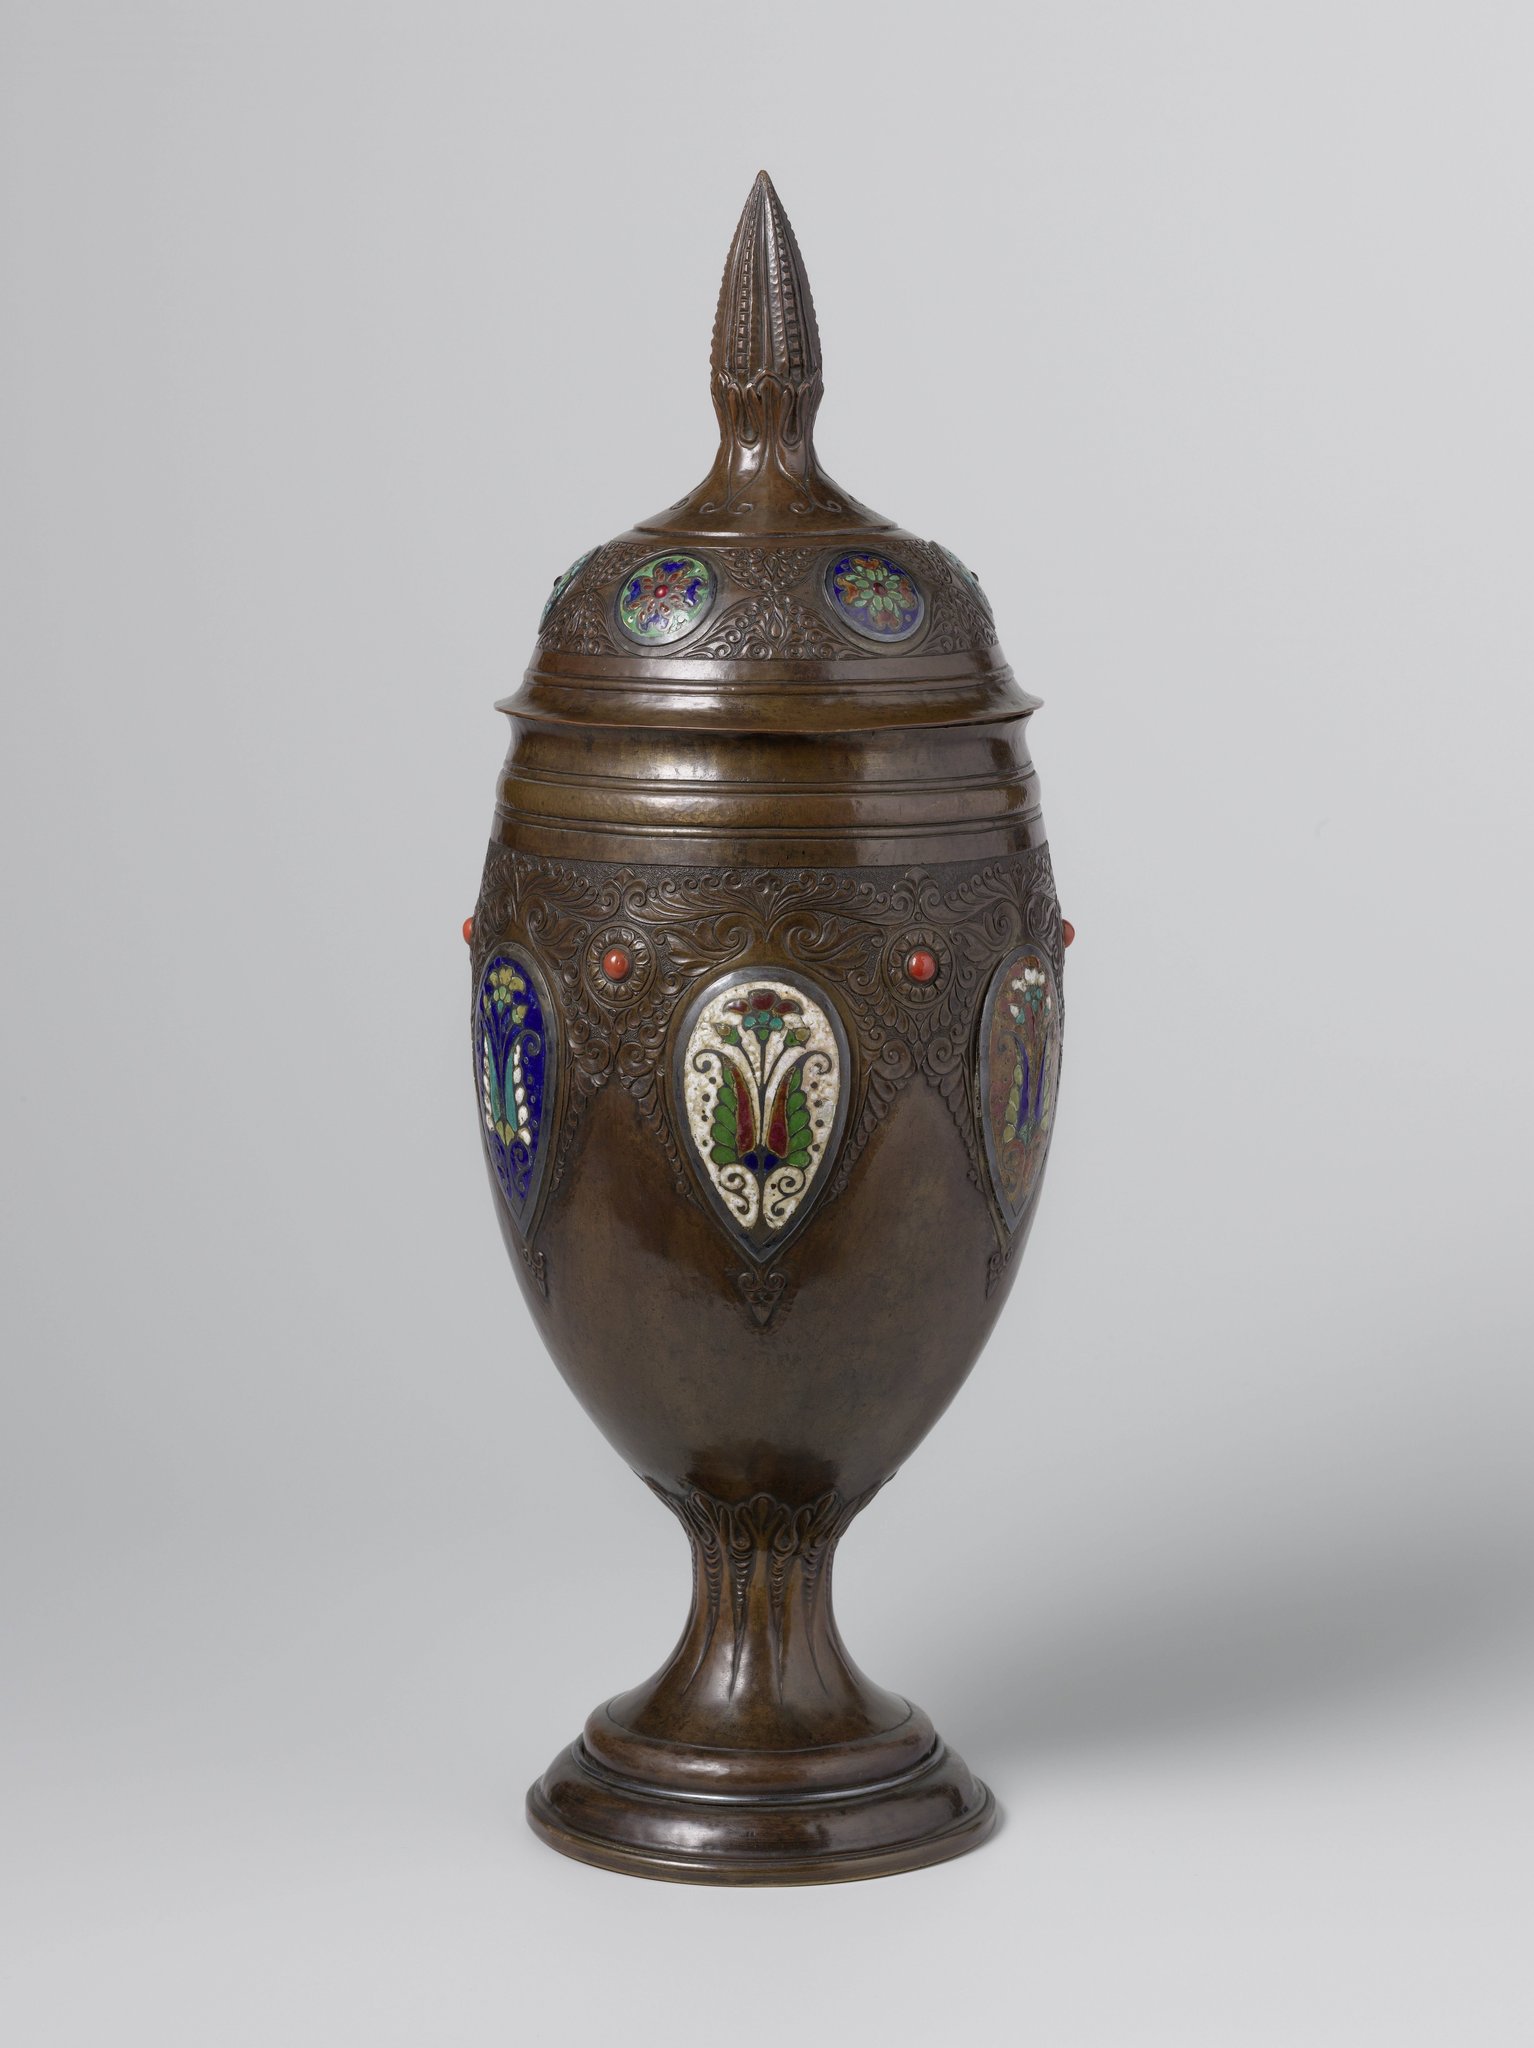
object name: goblet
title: Bokaal met deksel met zes geëmailleerde schilden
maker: george henri lantman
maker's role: designer, jeweler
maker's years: 1875-1932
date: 1911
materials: silver, metal alloy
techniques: punching, soldering, striking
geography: amsterdam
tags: wereldtentoonstelling 1925 (parijs)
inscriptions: label: ‘pour l'exposition a paris 1925 section néerlandaise’, label: ‘VIII 489’, signature: ‘G. H. LANTMAN / ME / FECIT / 1911’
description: Het ronde voorwerp bestaat uit een bokaal, die met de bodem in de voet uit één tombakplaat is geslagen, en een deksel. Onder de voetbodem is met twee bouten een uit tombak geslagen geprofileerde opstaande rand gemonteerd. Op bokaal en deksel zijn telkens zes geëmailleerde zilveren schilden gesoldeerd. De bokaal is aan de onderkant in de voet gesigneerd. G. H. LANTMAN / ME / FECIT / 1911. Aan de binnenkant van het deksel het etiket met de gedrukte tekst 'pour l'exposition a paris 1925 section néerlandaise' en in inkt 'VIII 489'. De bokaal is opgebouwd uit een voet, een stam en een kuip, welke in elkaar overlopen. De overgang van de stam naar de kuip heeft een gedreven gestileerd ornament, dat wordt gevormd door een twaalf keer herhaald motief, met bovenaan een in drieën geleed blad. Op de wand van de kuip zijn zes zilveren schilden gesoldeerd met een in cloisonné-techniek uitgevoerde vegetatieve versiering in email, bestaande uit een op stengels geplaatste bloemkelk en twee knoppen alsmede twee bladeren tegen een witte, blauwe of roodbruine achtergrond. De van boven ronde en naar beneden spits toelopende zilveren schilden zijn gevat in een gedreven en geponst decor, bestaande uit krullen, bladeren en zes rozetten, waarin een koraal is opgenomen. Deze reliëfversiering wordt bovenaan afgesloten door een geribde en holrond geprofileerde rand. Het deksel is voorzien van een knop, die in vorm en ornament enigszins doet denken aan een maiskolf. Hij wordt onderaan omsloten door zes bladeren, welke van dezelfde vorm zijn als die van de stam. Op het bolle gedeelte van het deksel zijn zes ronde zilveren schilden gesoldeerd met een geëmailleerde in cloisonné-techniek uitgevoerde versiering bestaande uit rozetten in blauw, groen en roodbruin en met een robijnrode halfedelsteen in het middelpunt. De schilden zijn omgeven door een gedreven en geponst decor, dat uit een stilering van krullen is opgebouwd.